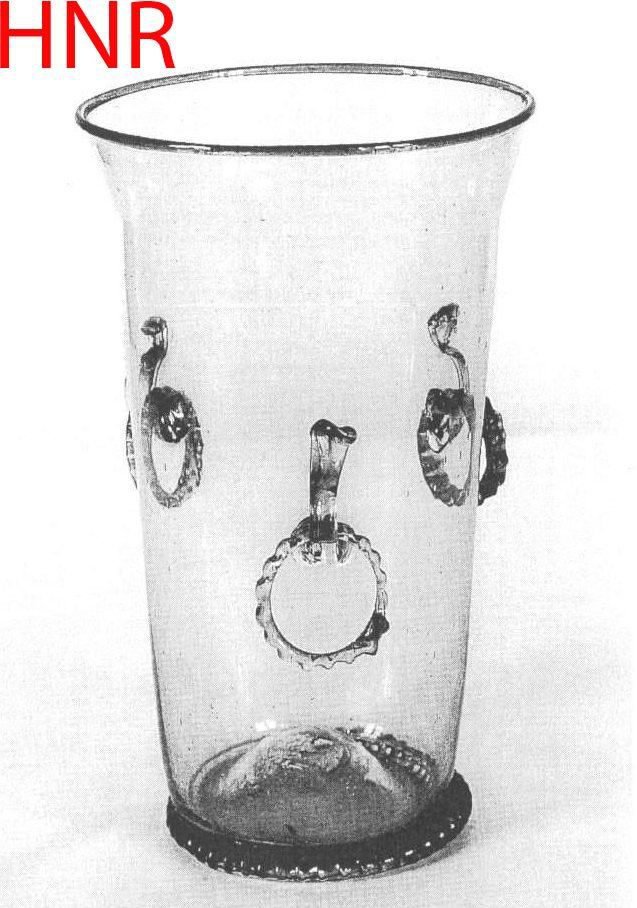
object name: ringbeker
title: Beaker with three loops with pendant rings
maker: Anonymous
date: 1600-1650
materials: glass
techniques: façon de venise, glassblowing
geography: netherlands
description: Glas à la façon de Venise. Ingestoken bodem. Gekerfde voetrand. Cilindrisch, aan de bovenzijde zich verwijdend lichaam, waarop drie lussen met ringen. Langs de mondrand een blauwe draad.